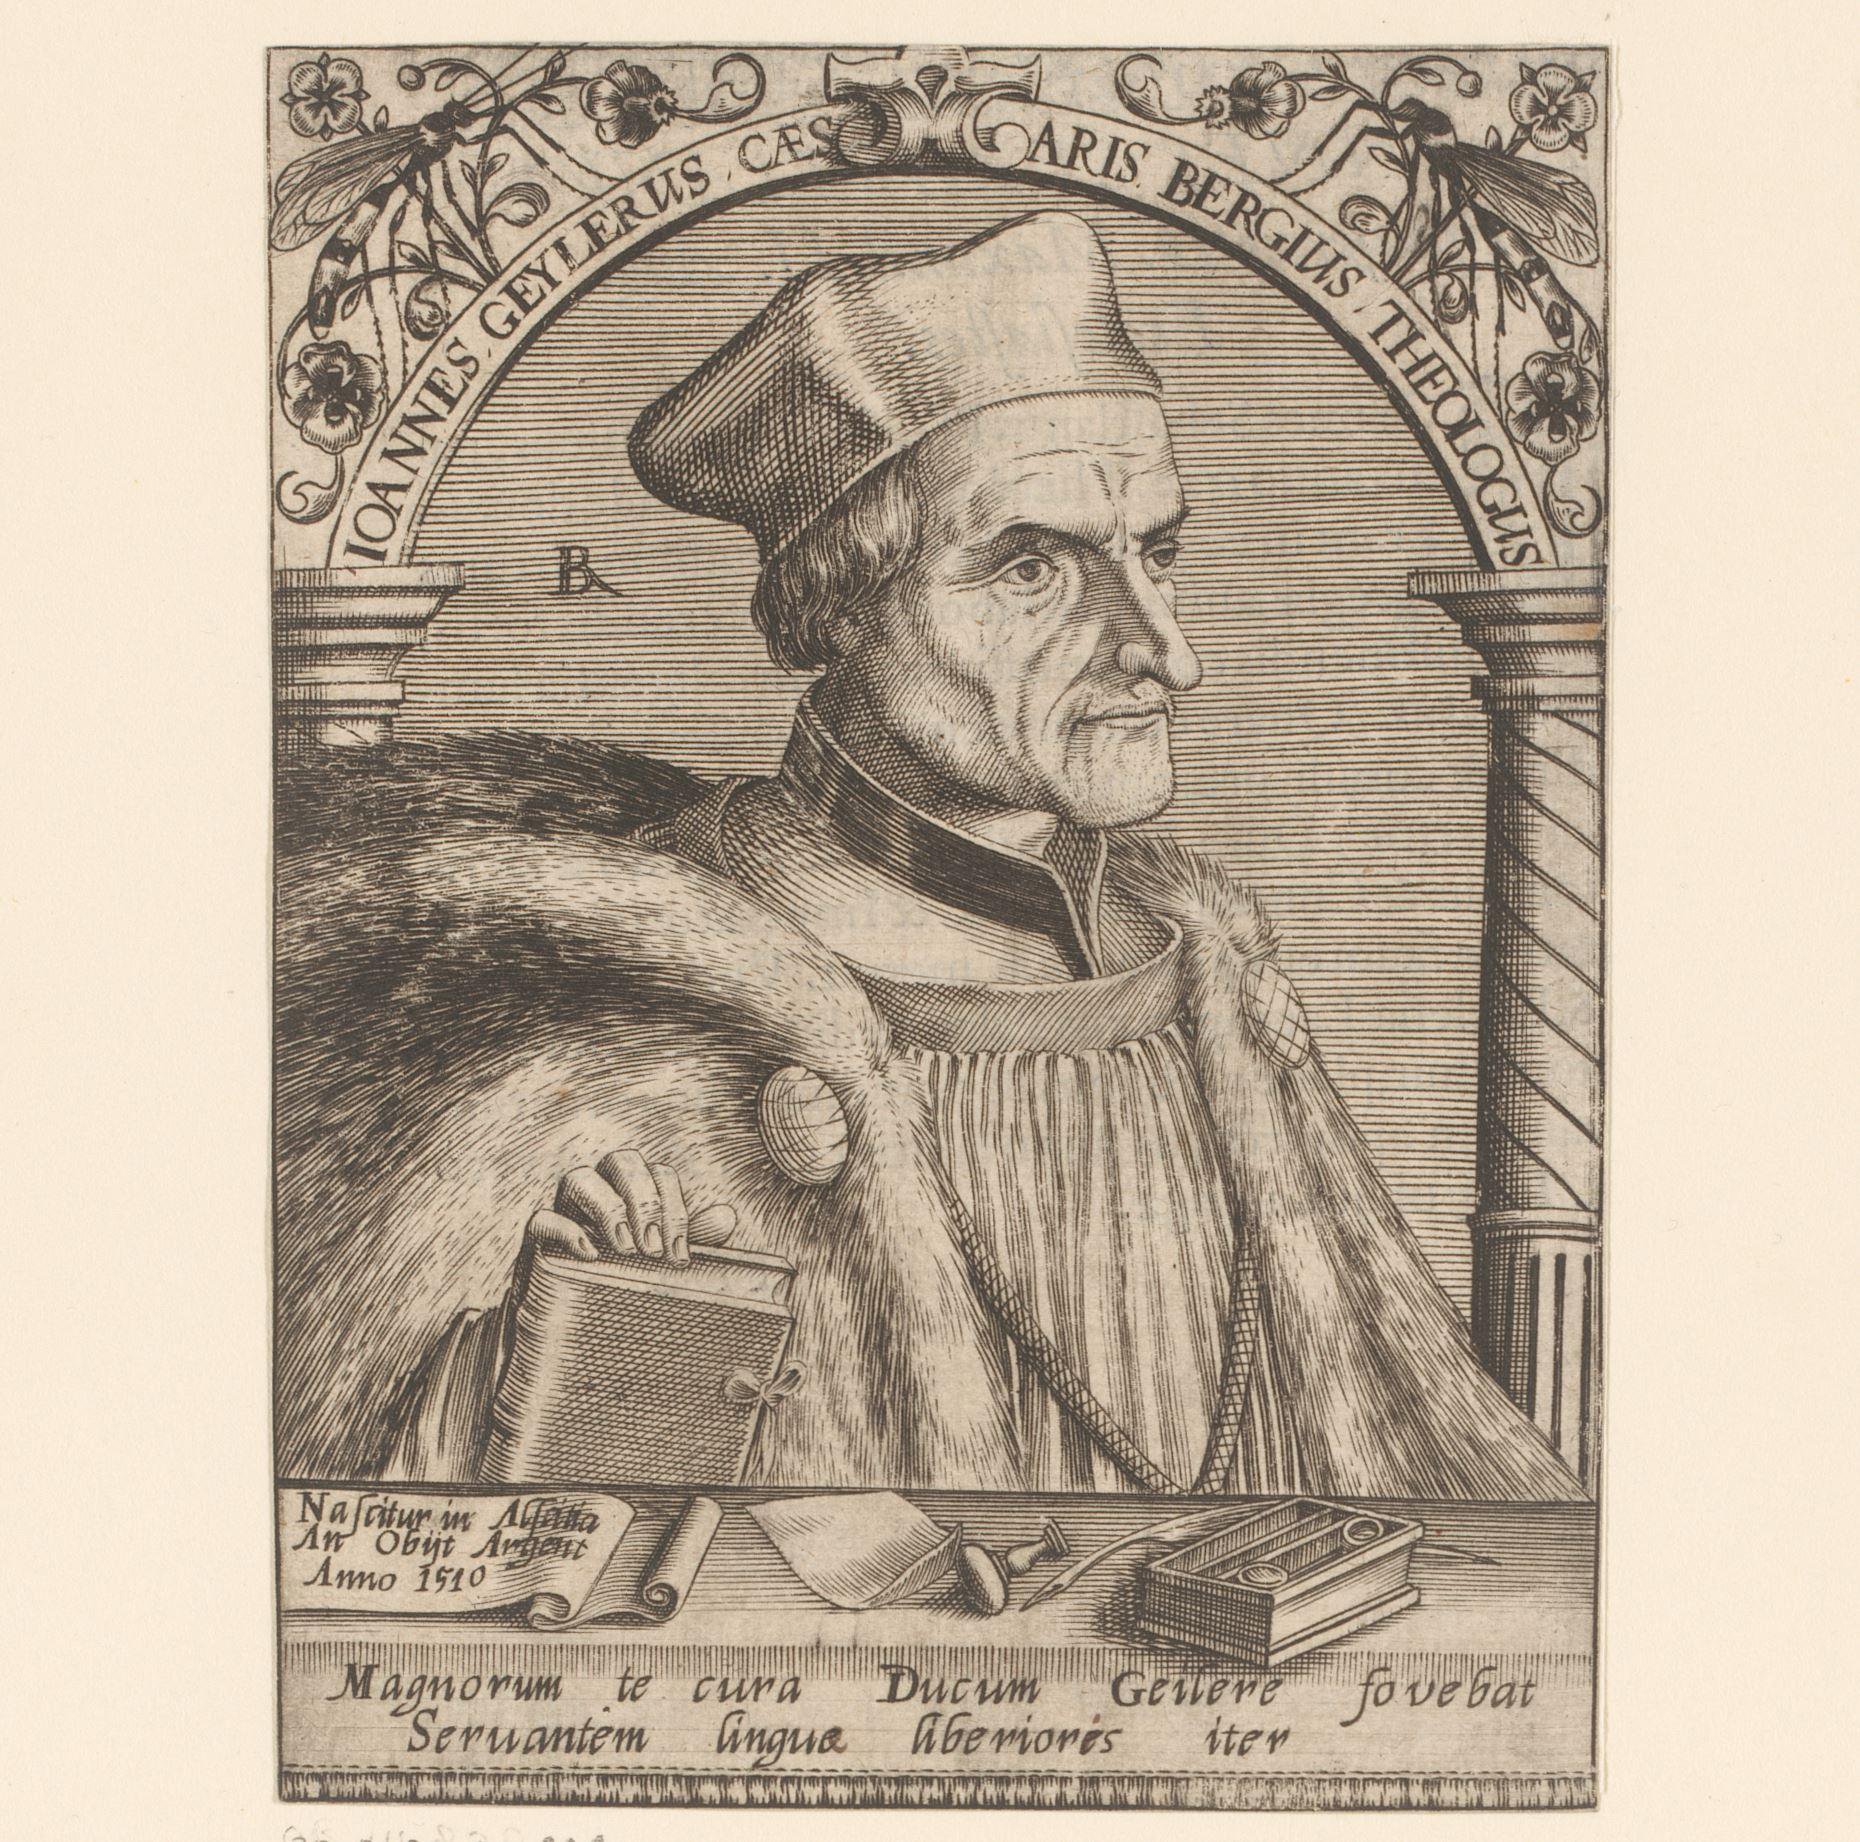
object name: print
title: Serie portretten van vijftiende- en zestiende-eeuwse geleerden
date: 1597-1599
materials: paper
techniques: engraving, letterpress printing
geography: france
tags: insects: dragon-fly, ink-well, historical persons, book